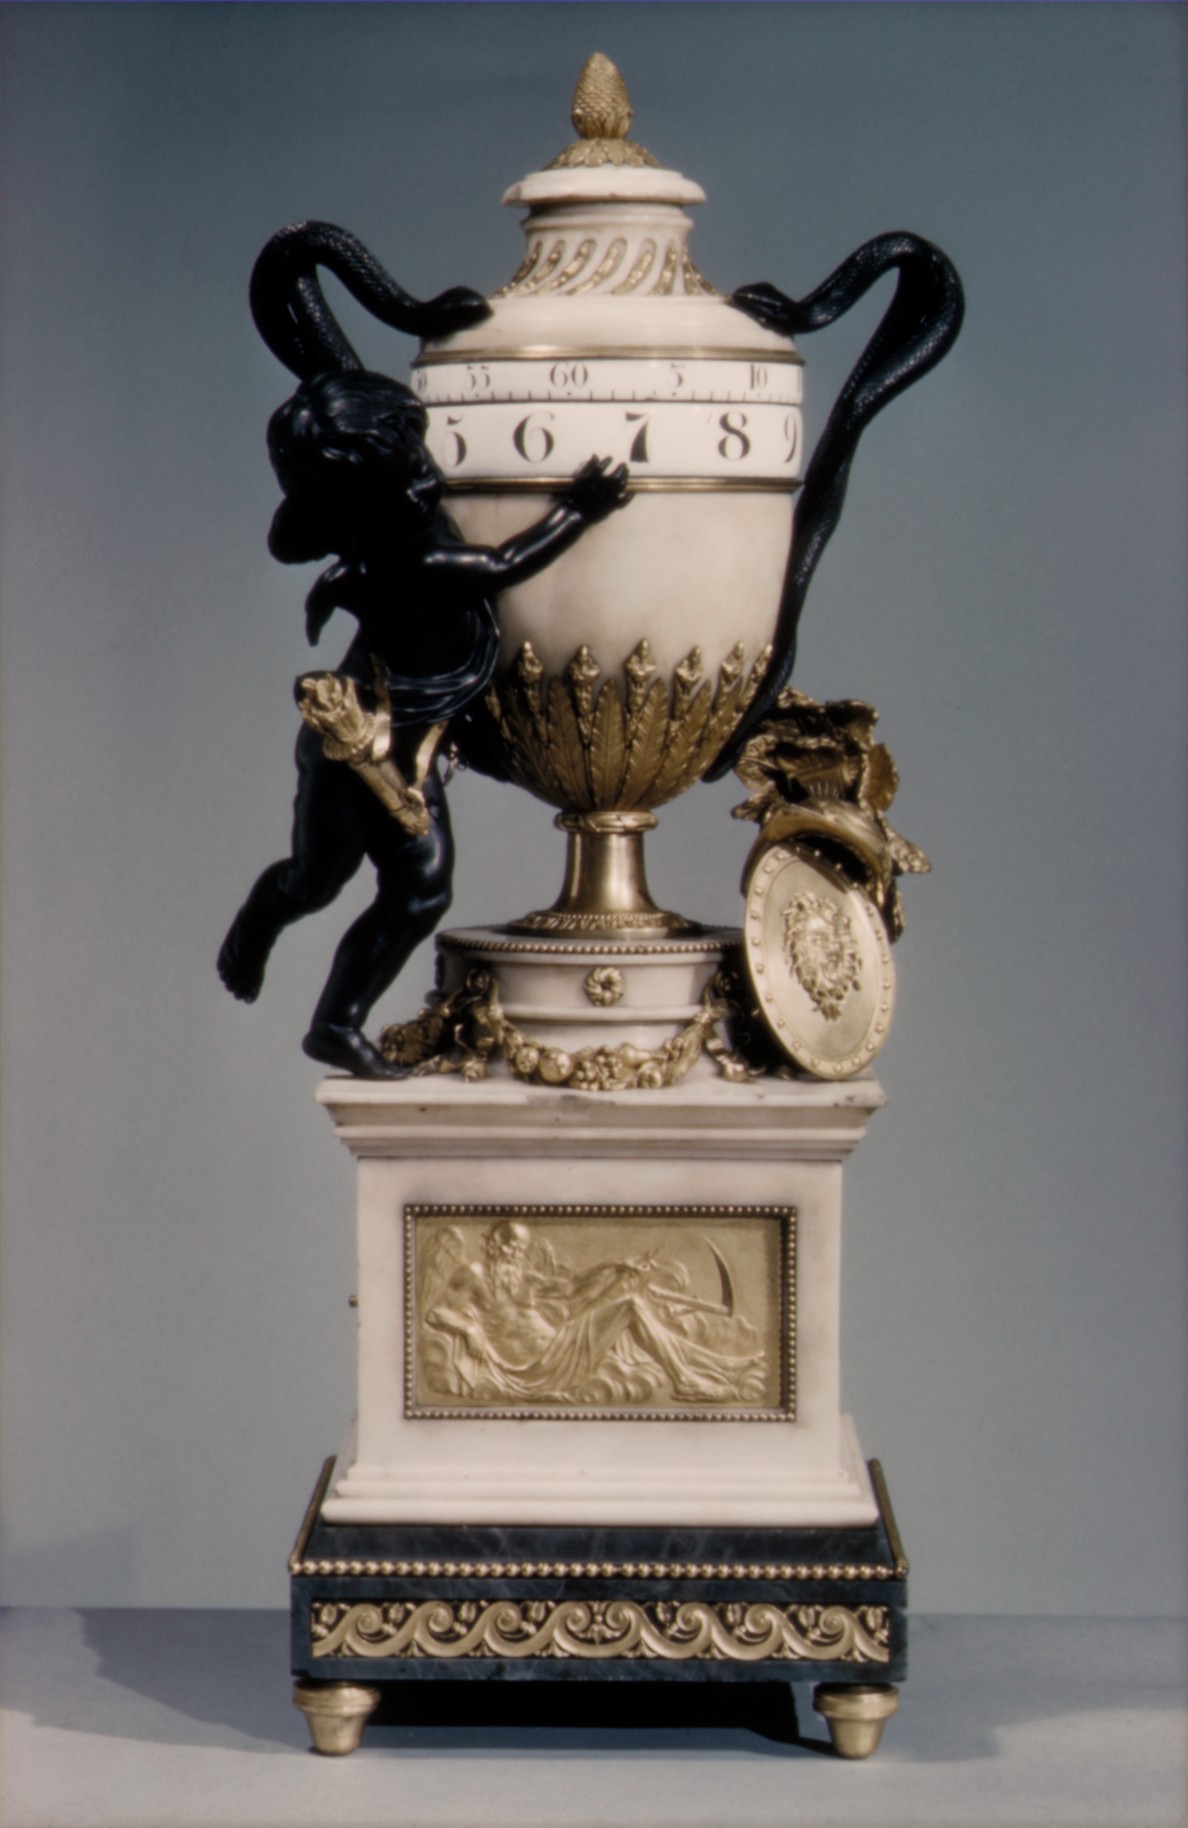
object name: clock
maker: jean-baptiste lepaute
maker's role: maker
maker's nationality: french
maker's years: 1727-1802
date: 1775-1780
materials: brass, bronze, enamel, gilt bronze, marble, steel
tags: cupid,serpents